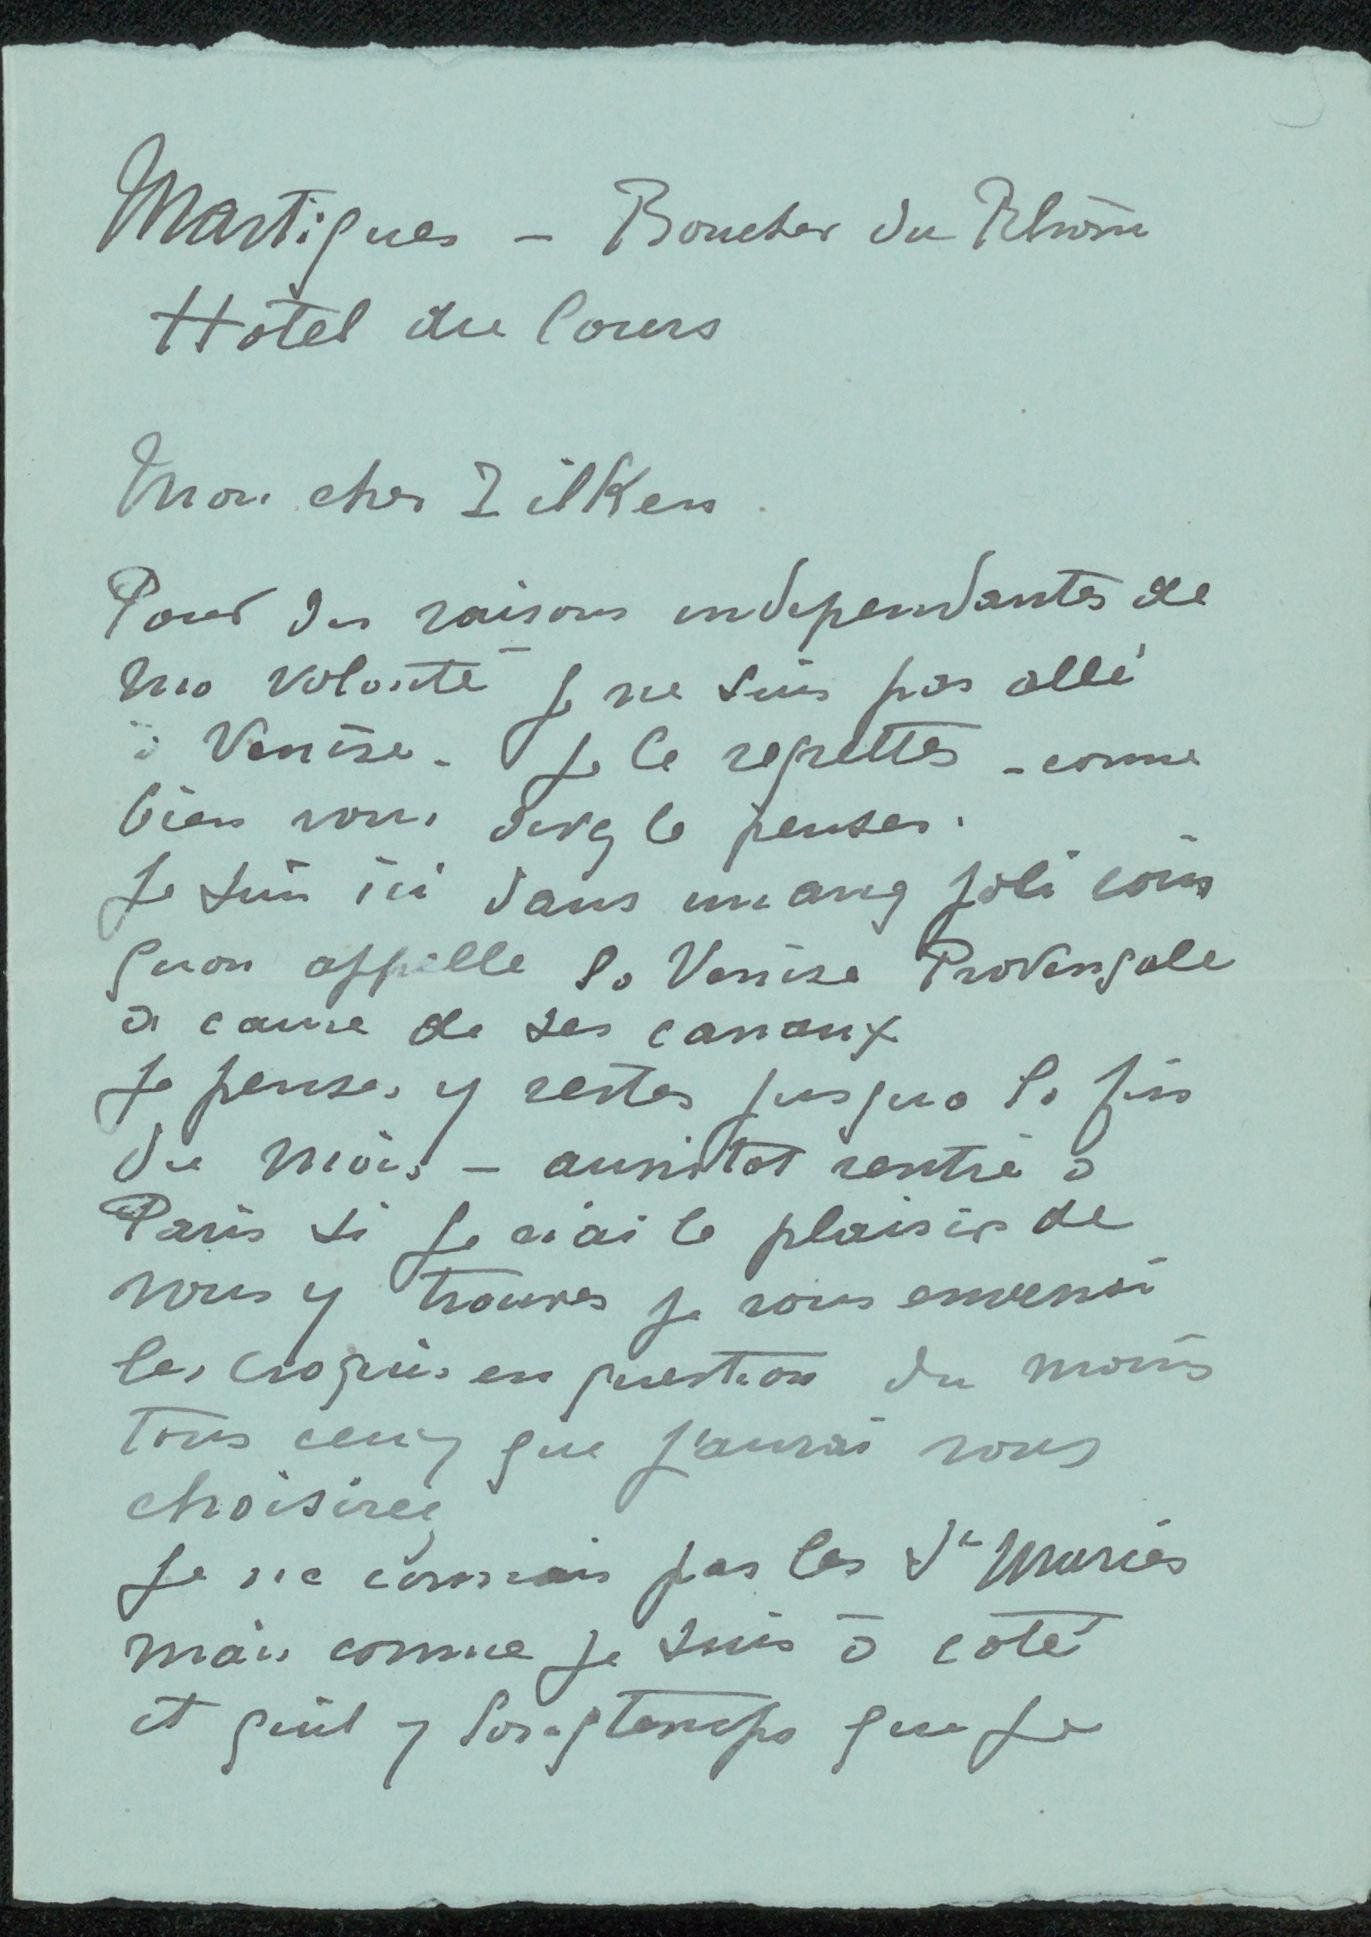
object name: letter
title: Brief aan Philip Zilcken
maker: henri pierre paillard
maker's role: painter, print maker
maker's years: 1844-1912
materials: ink, paper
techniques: pen, writing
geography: bouches-du-rhône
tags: the hague, painter, philip zilcken, venice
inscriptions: collector's mark: ‘RPK’